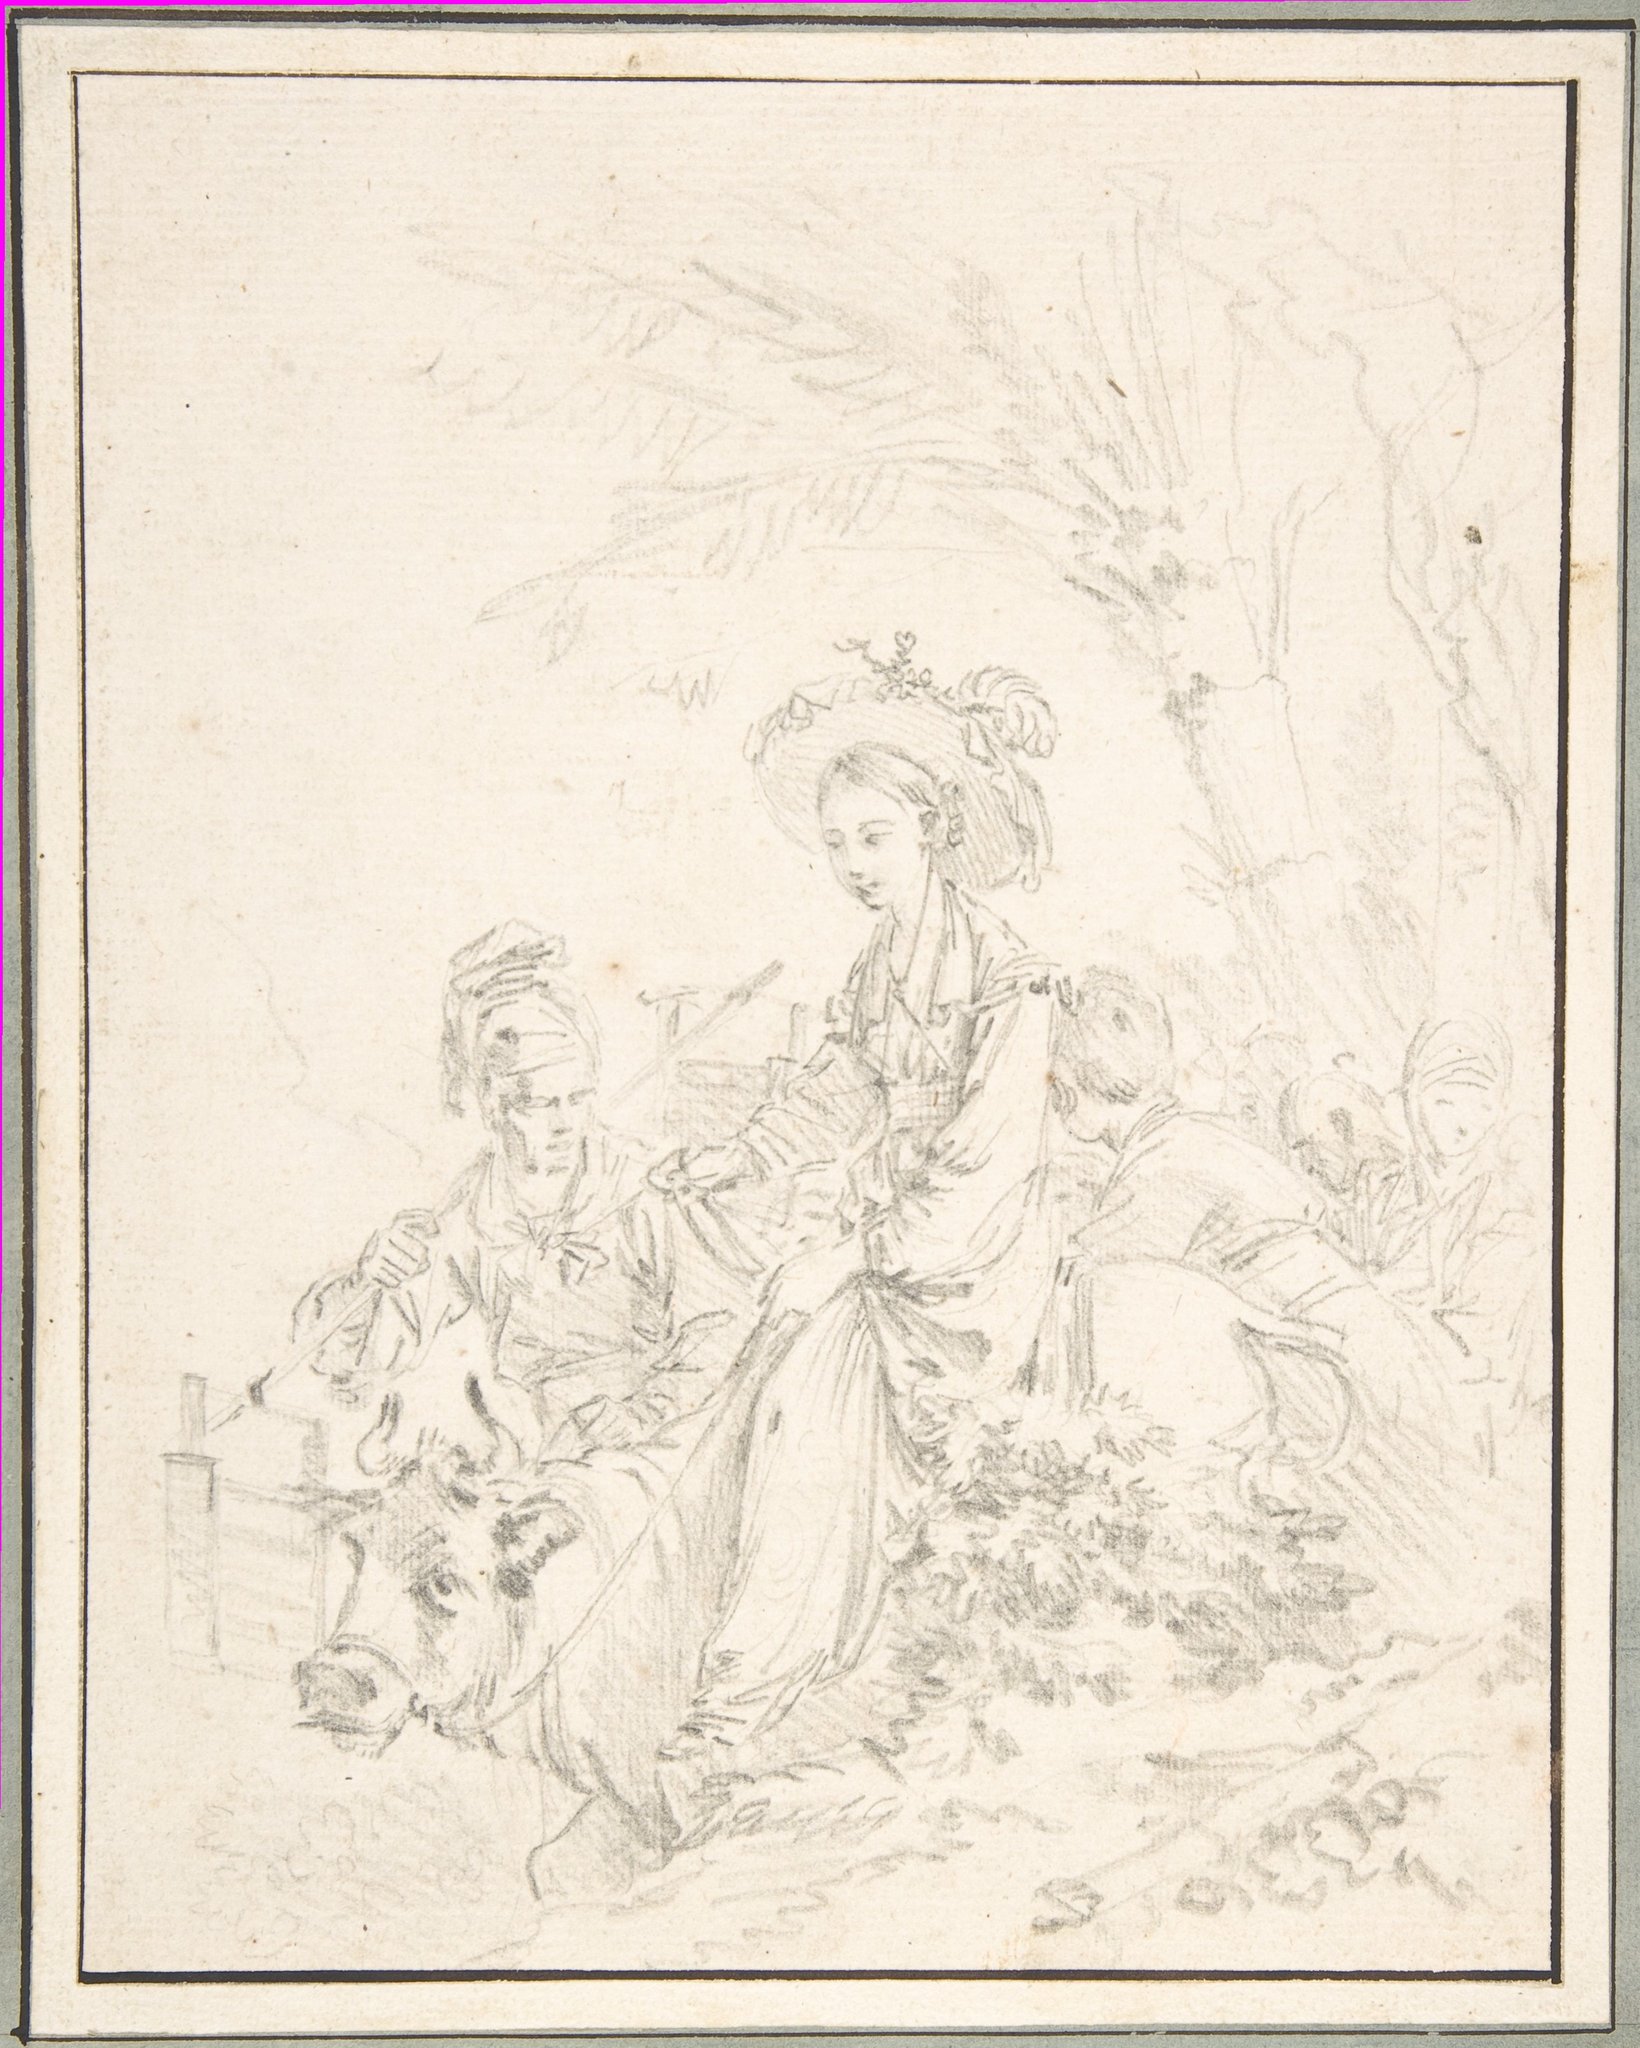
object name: drawing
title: Peasant Girl Riding an Ox with Companions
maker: françois boucher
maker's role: artist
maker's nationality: french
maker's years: 1703-1770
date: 1701-1800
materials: chalk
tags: animals,girls,men,trees